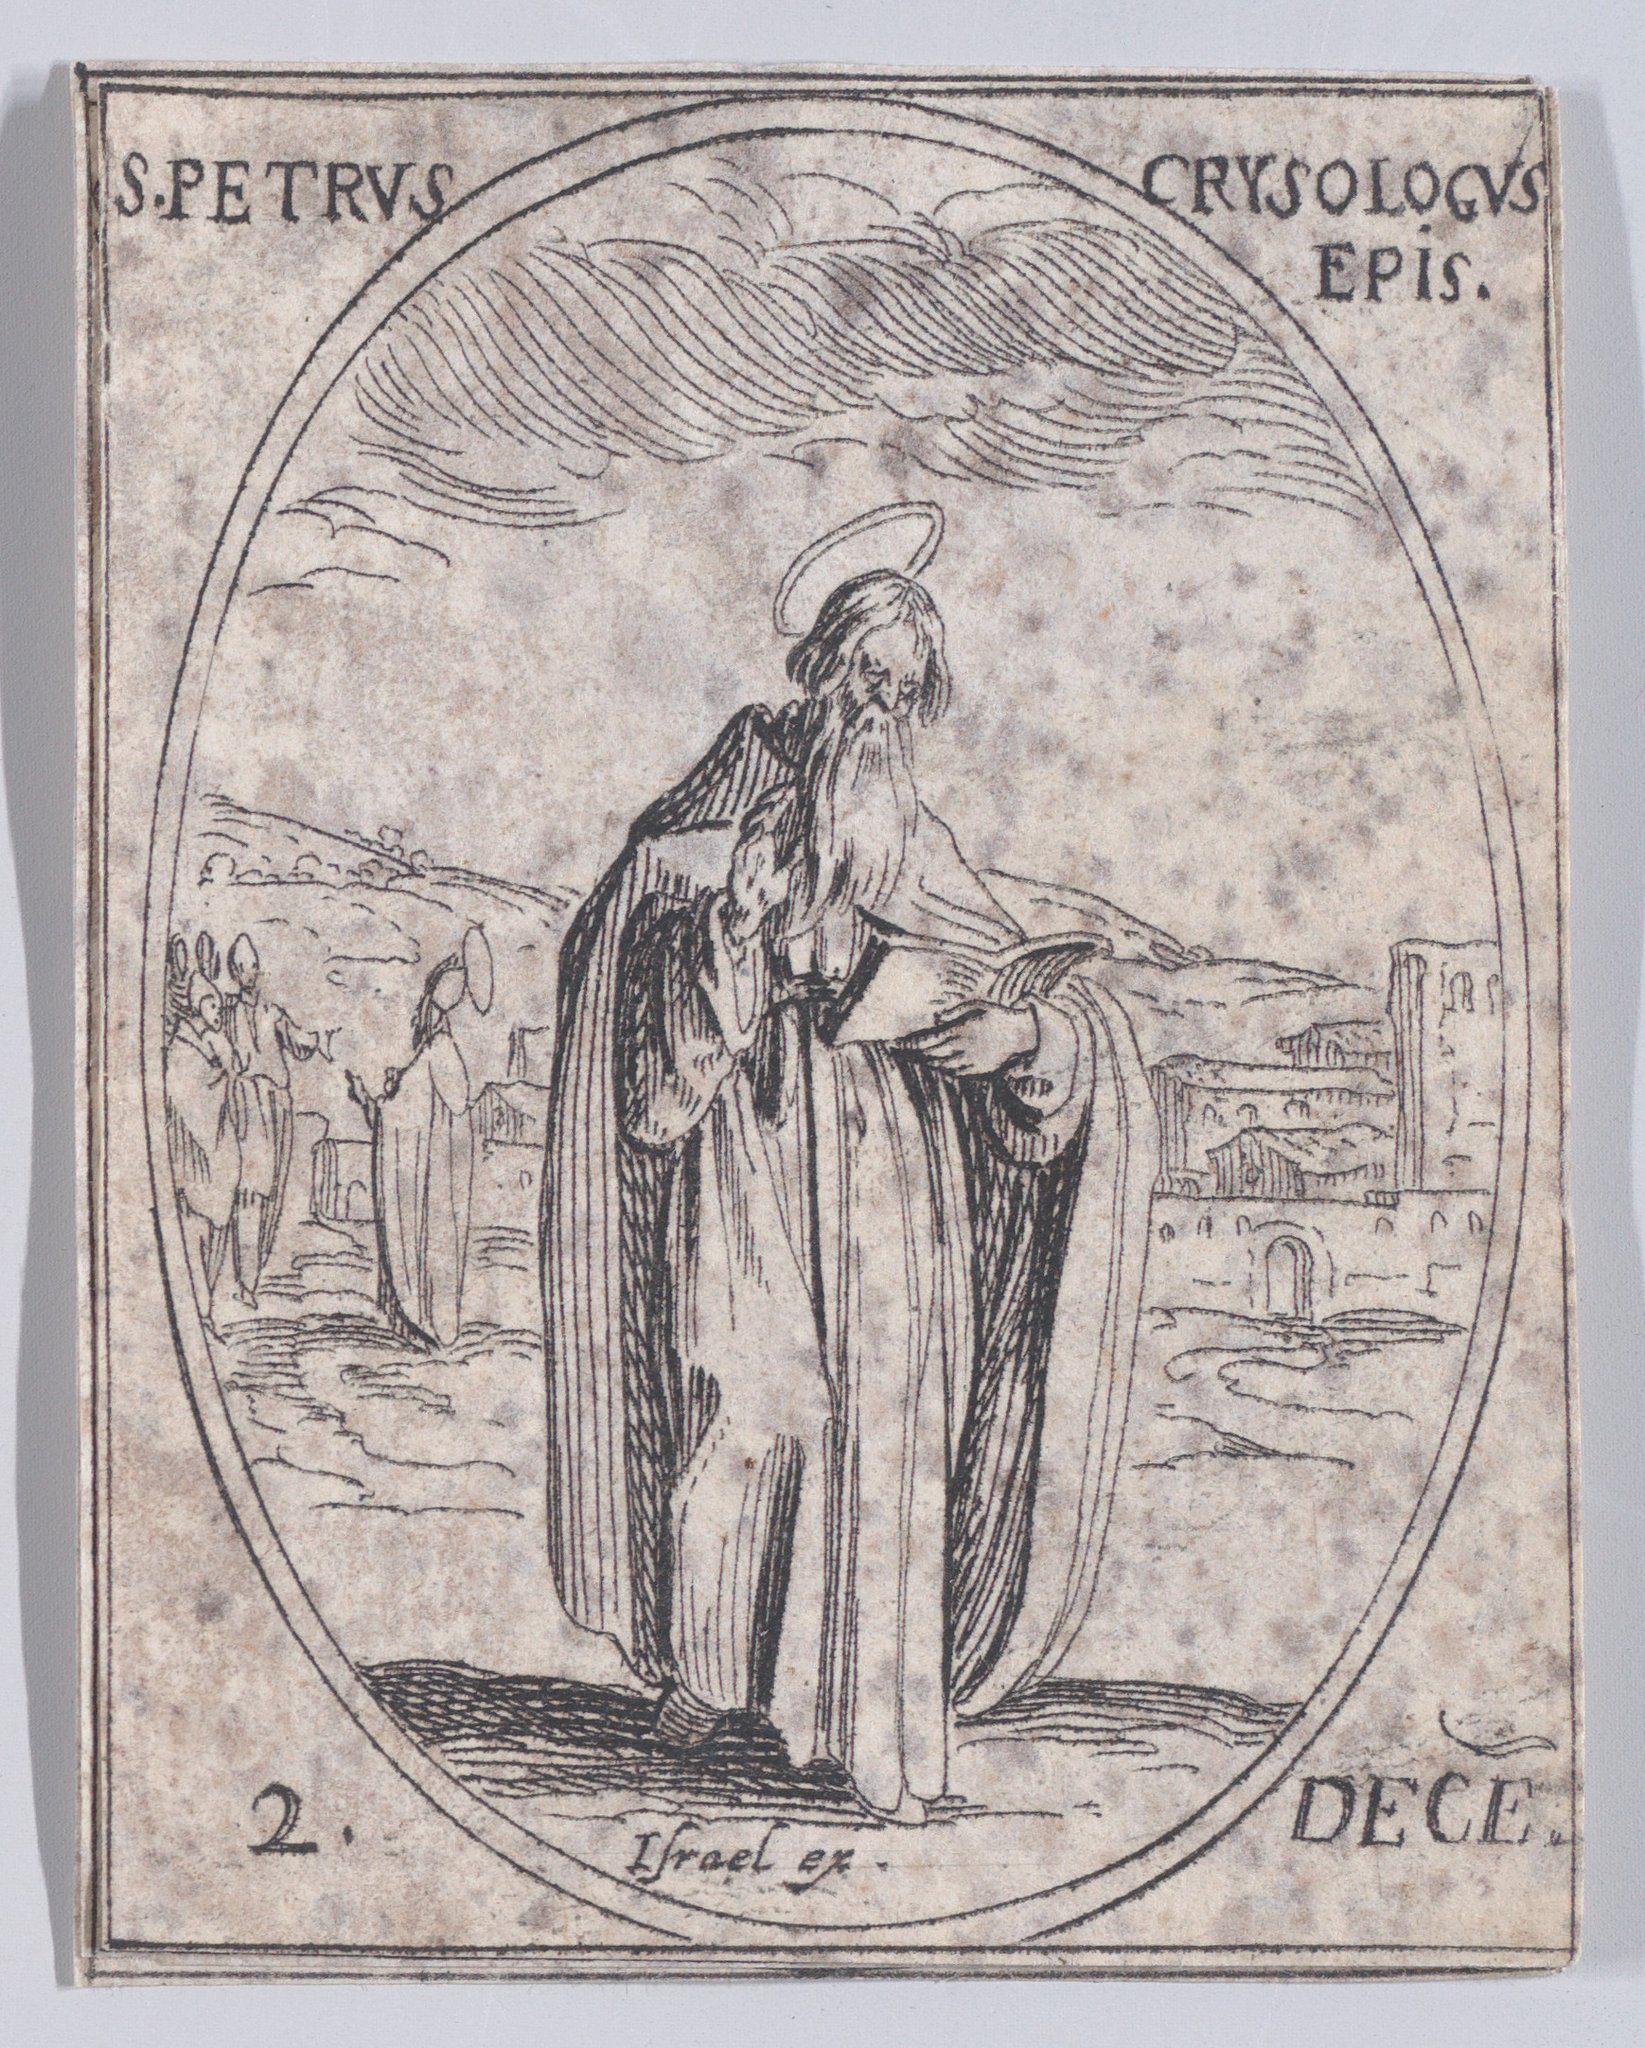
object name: print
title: S. Pierre Chrysologe, eveque (St. Peter Chrysologus, Bishop), December 2nd, from "Les Images De Tous Les Saincts et Saintes de L'Année" (Images of All of the Saints and Religious Events of the Year)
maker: jacques callot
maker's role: artist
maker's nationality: french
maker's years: 1592-1635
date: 1636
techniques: etching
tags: men,saints